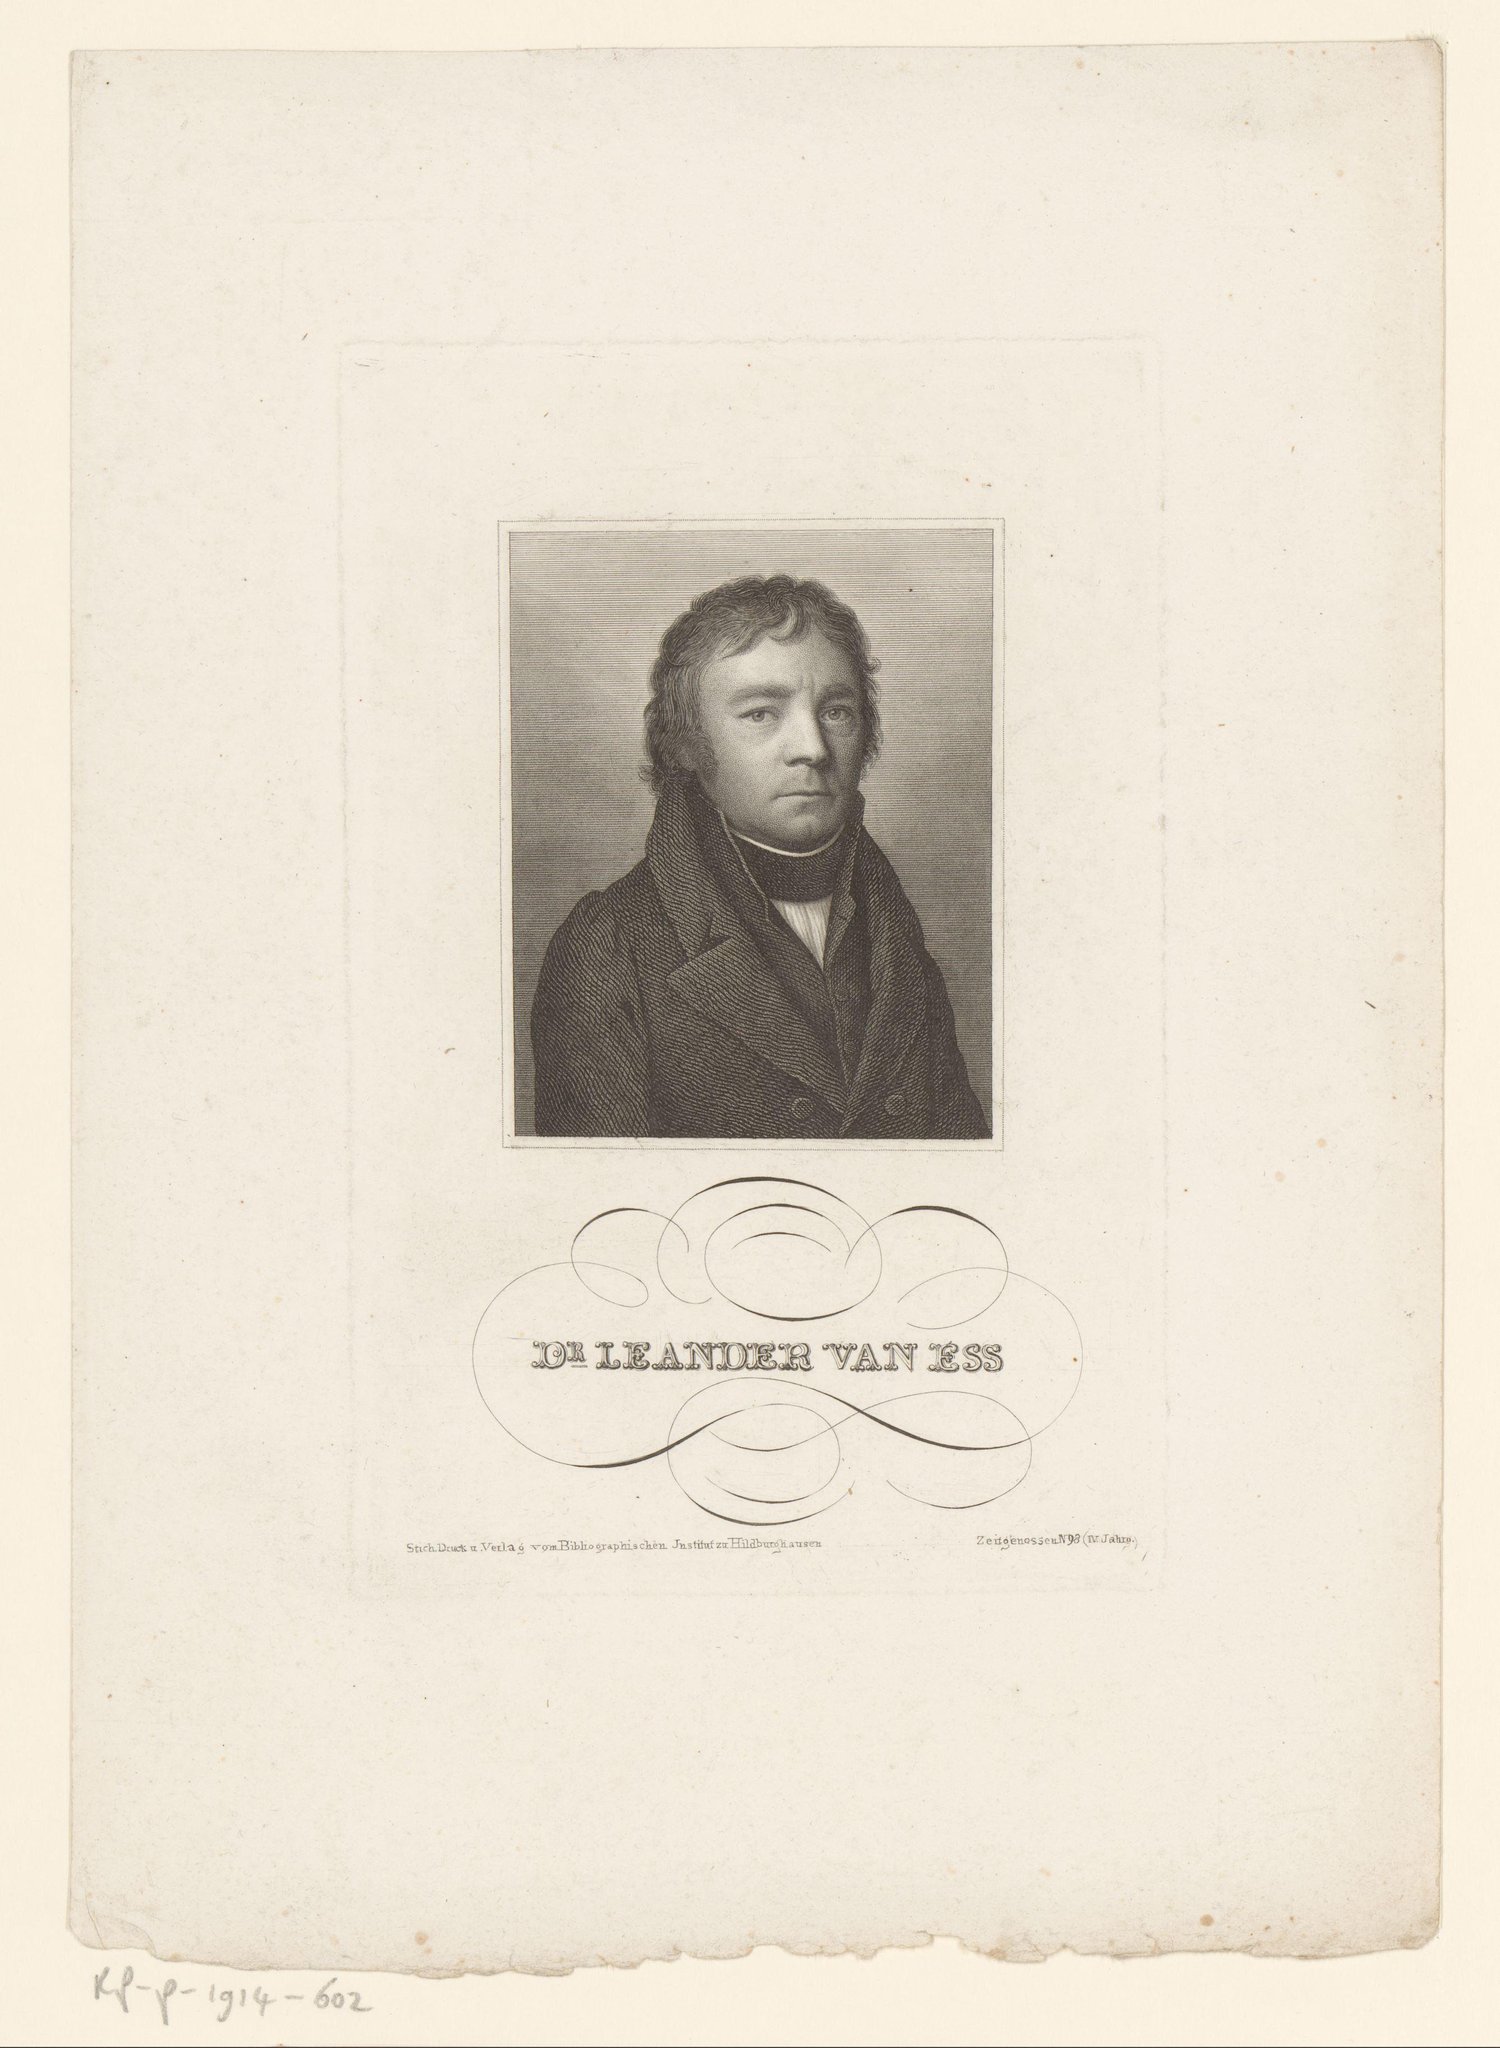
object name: print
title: Portret van Leander van Ess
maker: johann georg nordheim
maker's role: print maker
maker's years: 1804-1853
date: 1829-1840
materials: paper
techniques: engraving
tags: historical persons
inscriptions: collector's mark: Lugt 2228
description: Afkomstig uit de portretserie 'Zeitgenossen', uitgegeven tussen 1829 en circa 1840.